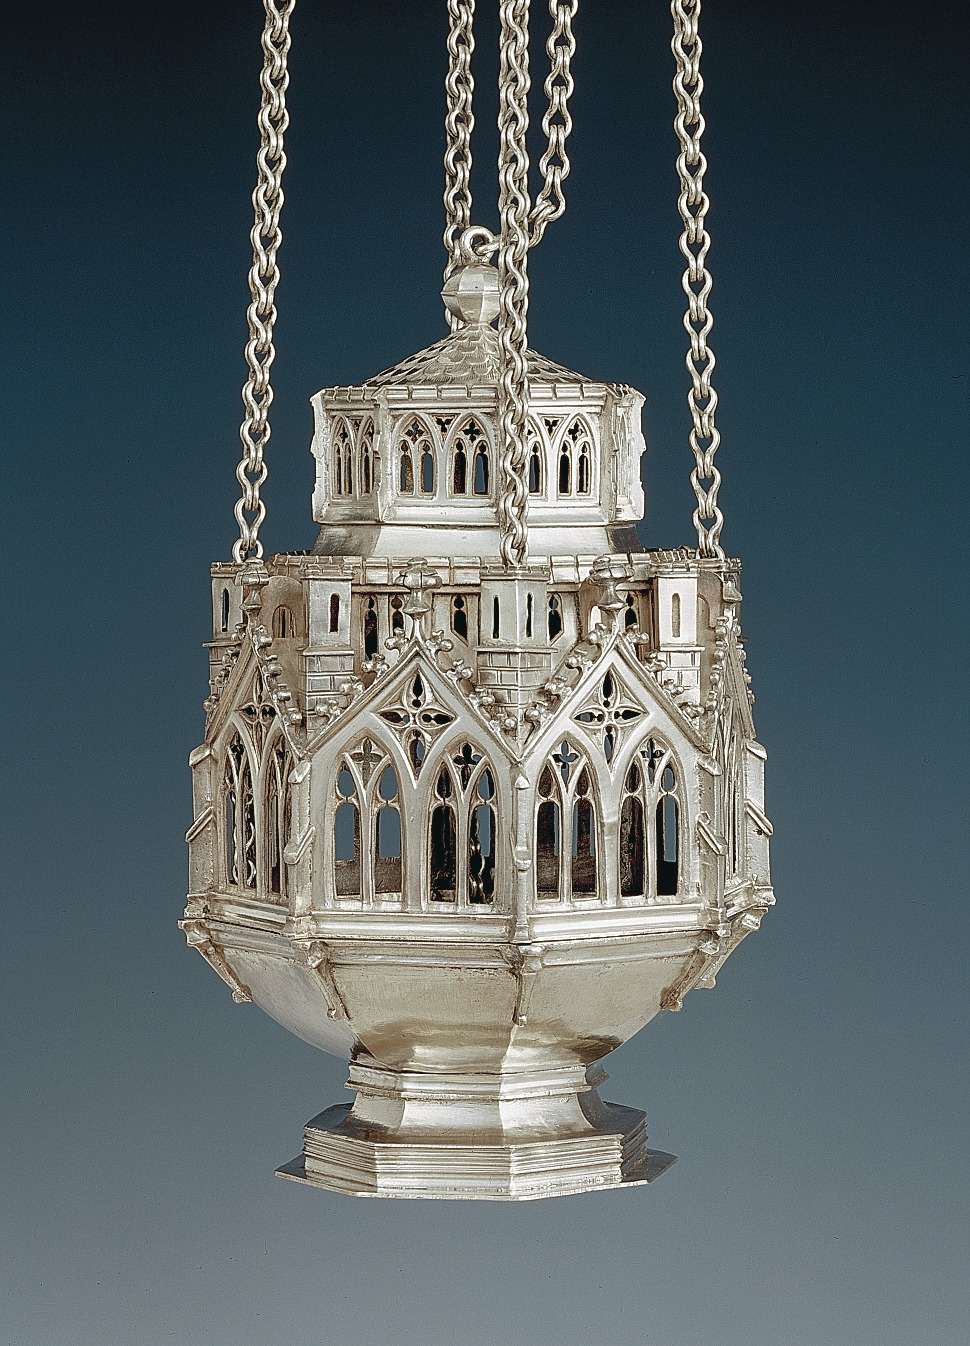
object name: censer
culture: german or swiss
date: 1842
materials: silver